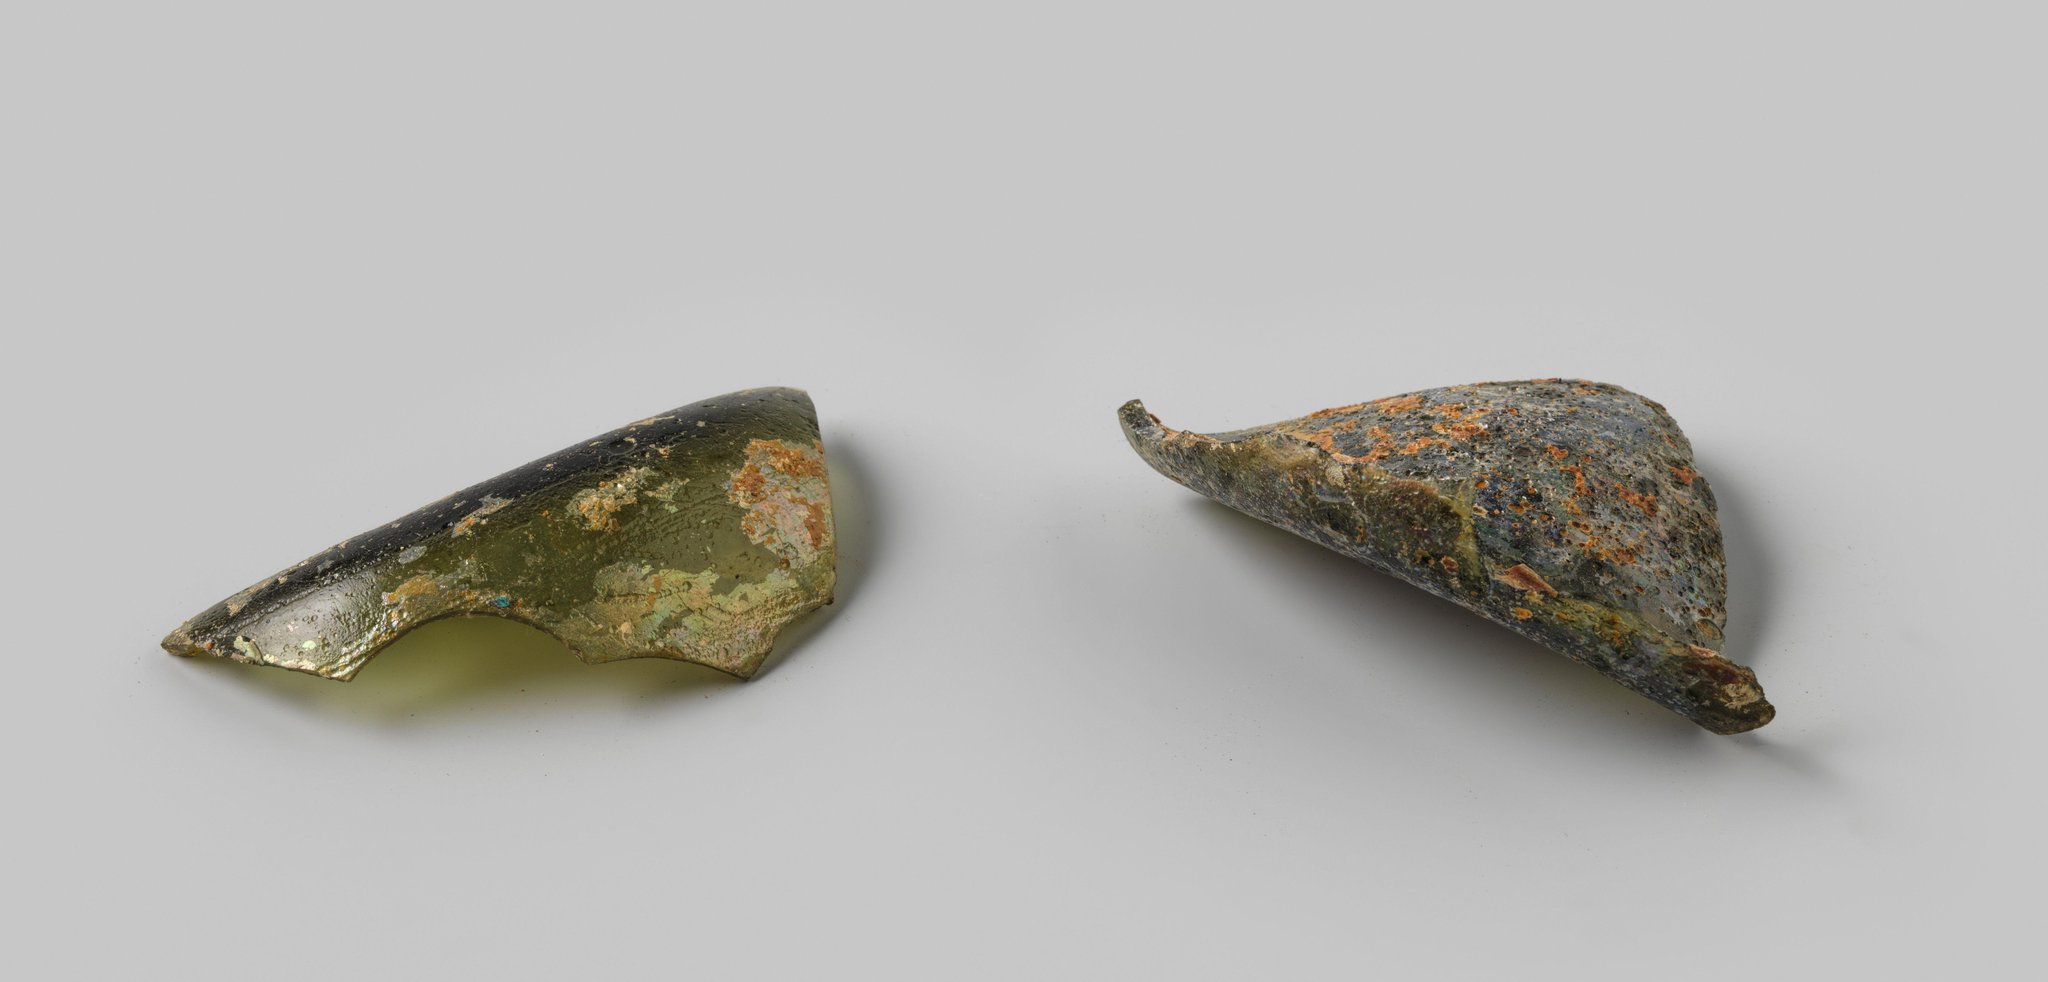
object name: wine bottle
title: Bodemfragmenten van wijnflessen uit het wrak van de Oost-Indiëvaarder Hollandia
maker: Anonymous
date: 1700-1743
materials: glass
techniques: green glass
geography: netherlands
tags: verenigde oostindische compagnie, hollandia (schip), annet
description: Typologically not identifiable, base, fragm.